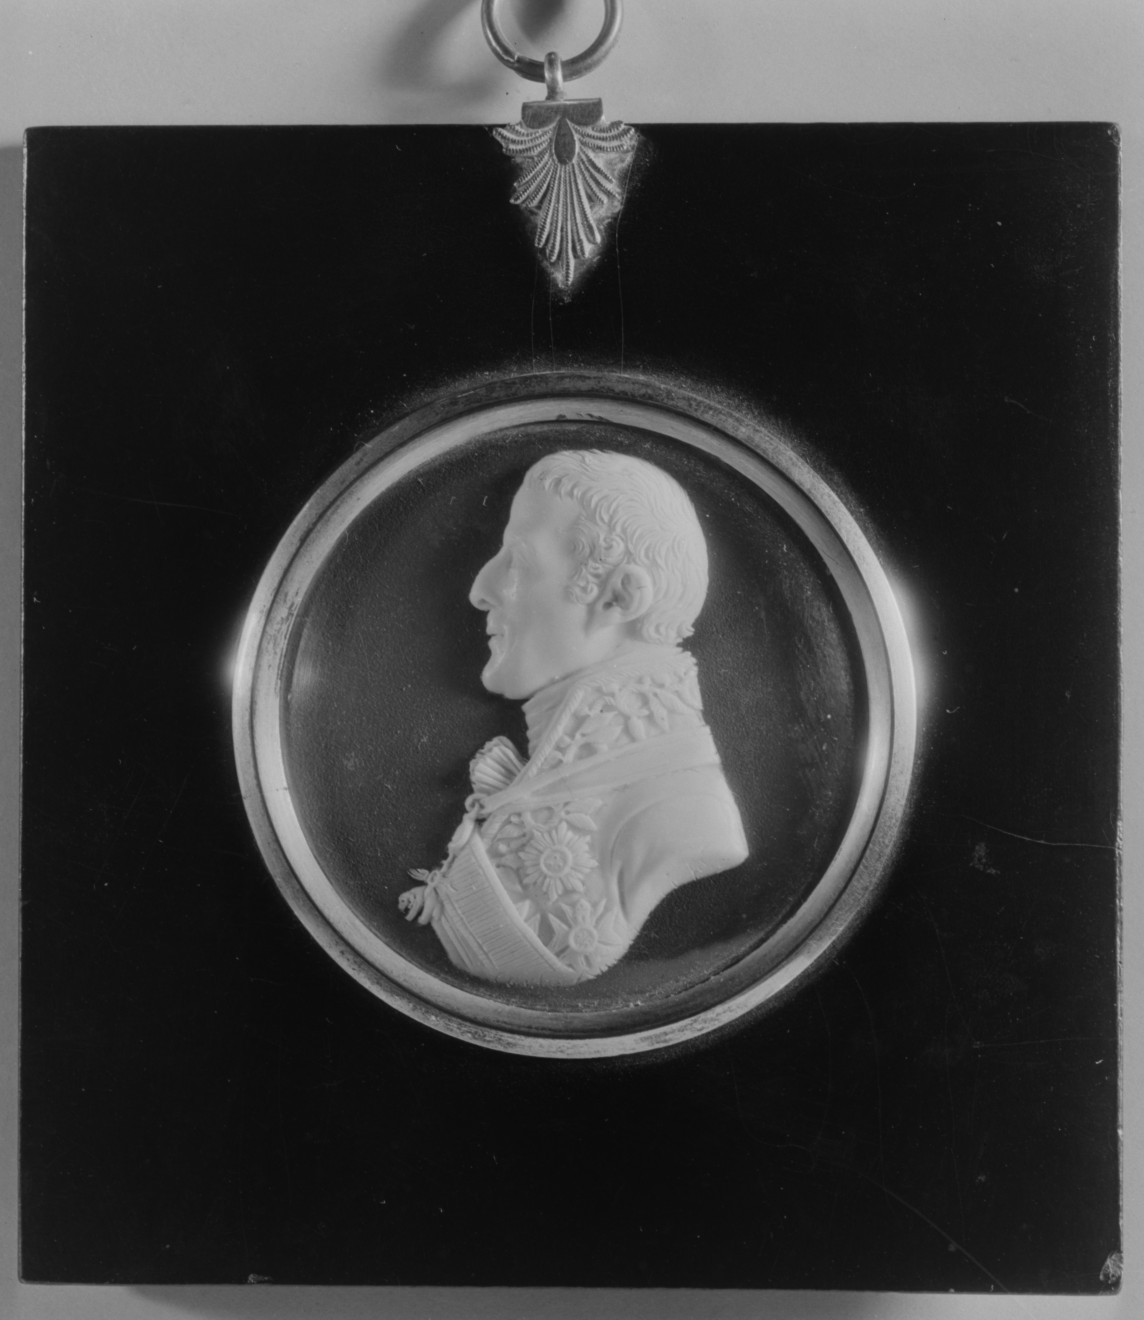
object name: medallion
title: Arthur Wellesley, Duke of Wellington (1769–1852)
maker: carlo amatucci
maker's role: artist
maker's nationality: italian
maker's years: 1719-1819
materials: gilt copper, paper, wax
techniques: lacquer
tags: men,profiles